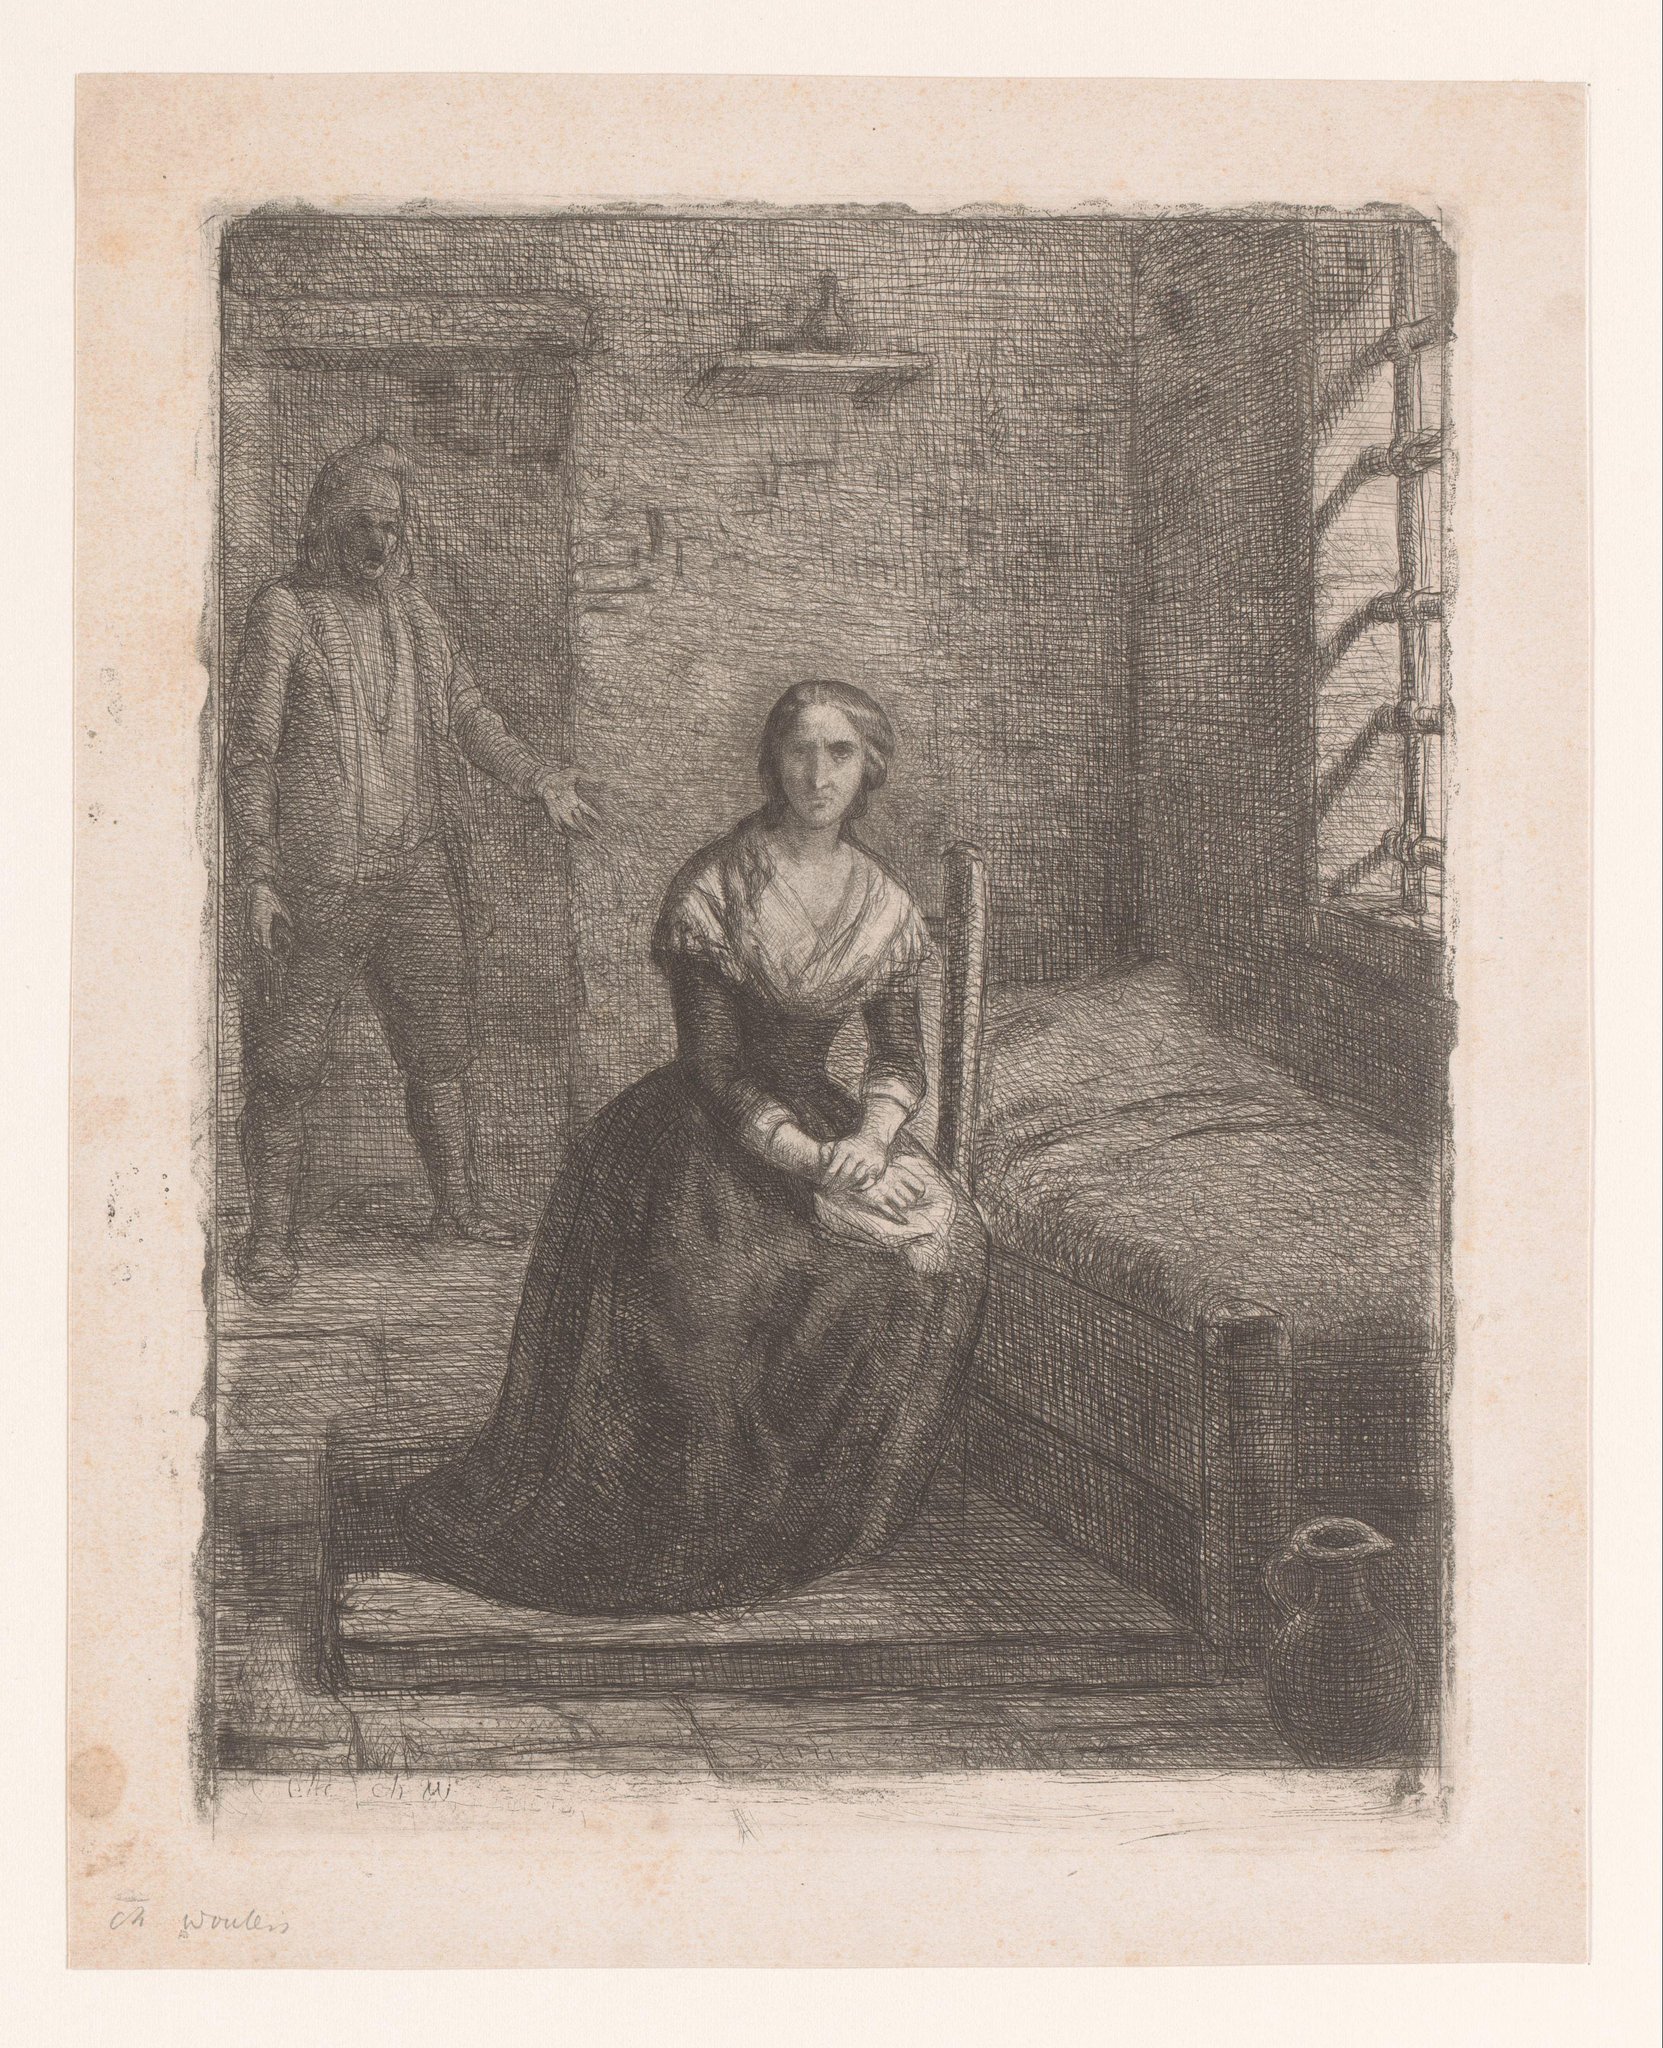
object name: print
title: Marie Antoinette gevangen in de Tour du Temple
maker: charles augustin wauters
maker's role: draughtsman, print maker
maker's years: 1811-1869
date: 1821-1869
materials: paper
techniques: etching, intaglio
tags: marie antoinette, adult woman, bed, imprisonment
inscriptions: collector's mark: Lugt 1485, collector's mark: Lugt 2228